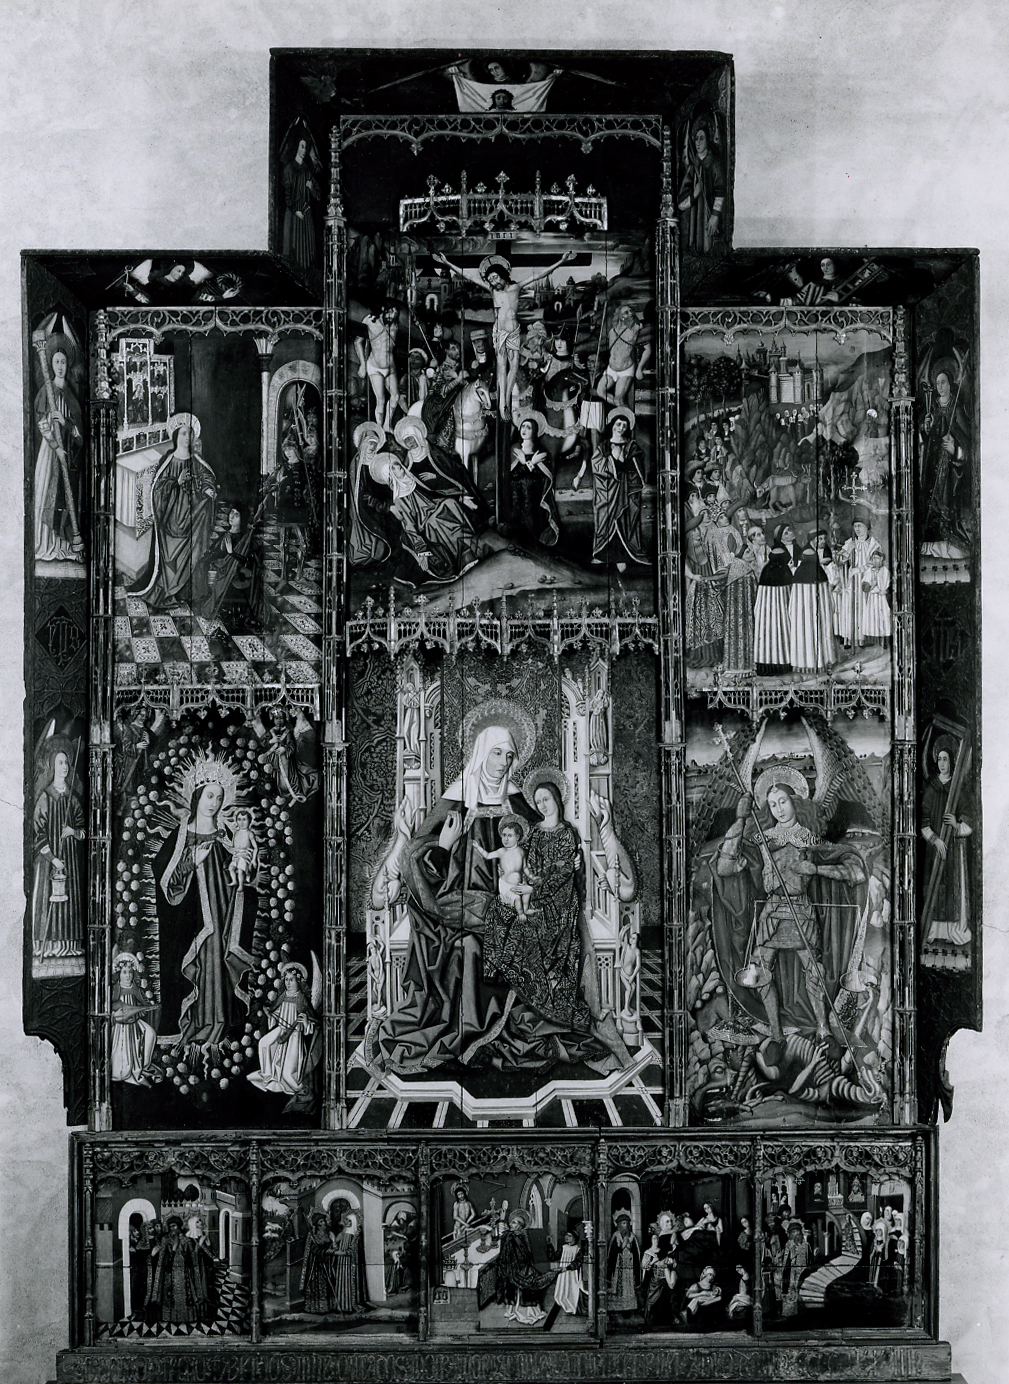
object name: painting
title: Saint Anne with the Virgin and Child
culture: spanish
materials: gold, oil, wood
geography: spain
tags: dragons,madonna and child,saint anne,crucifixion,saints